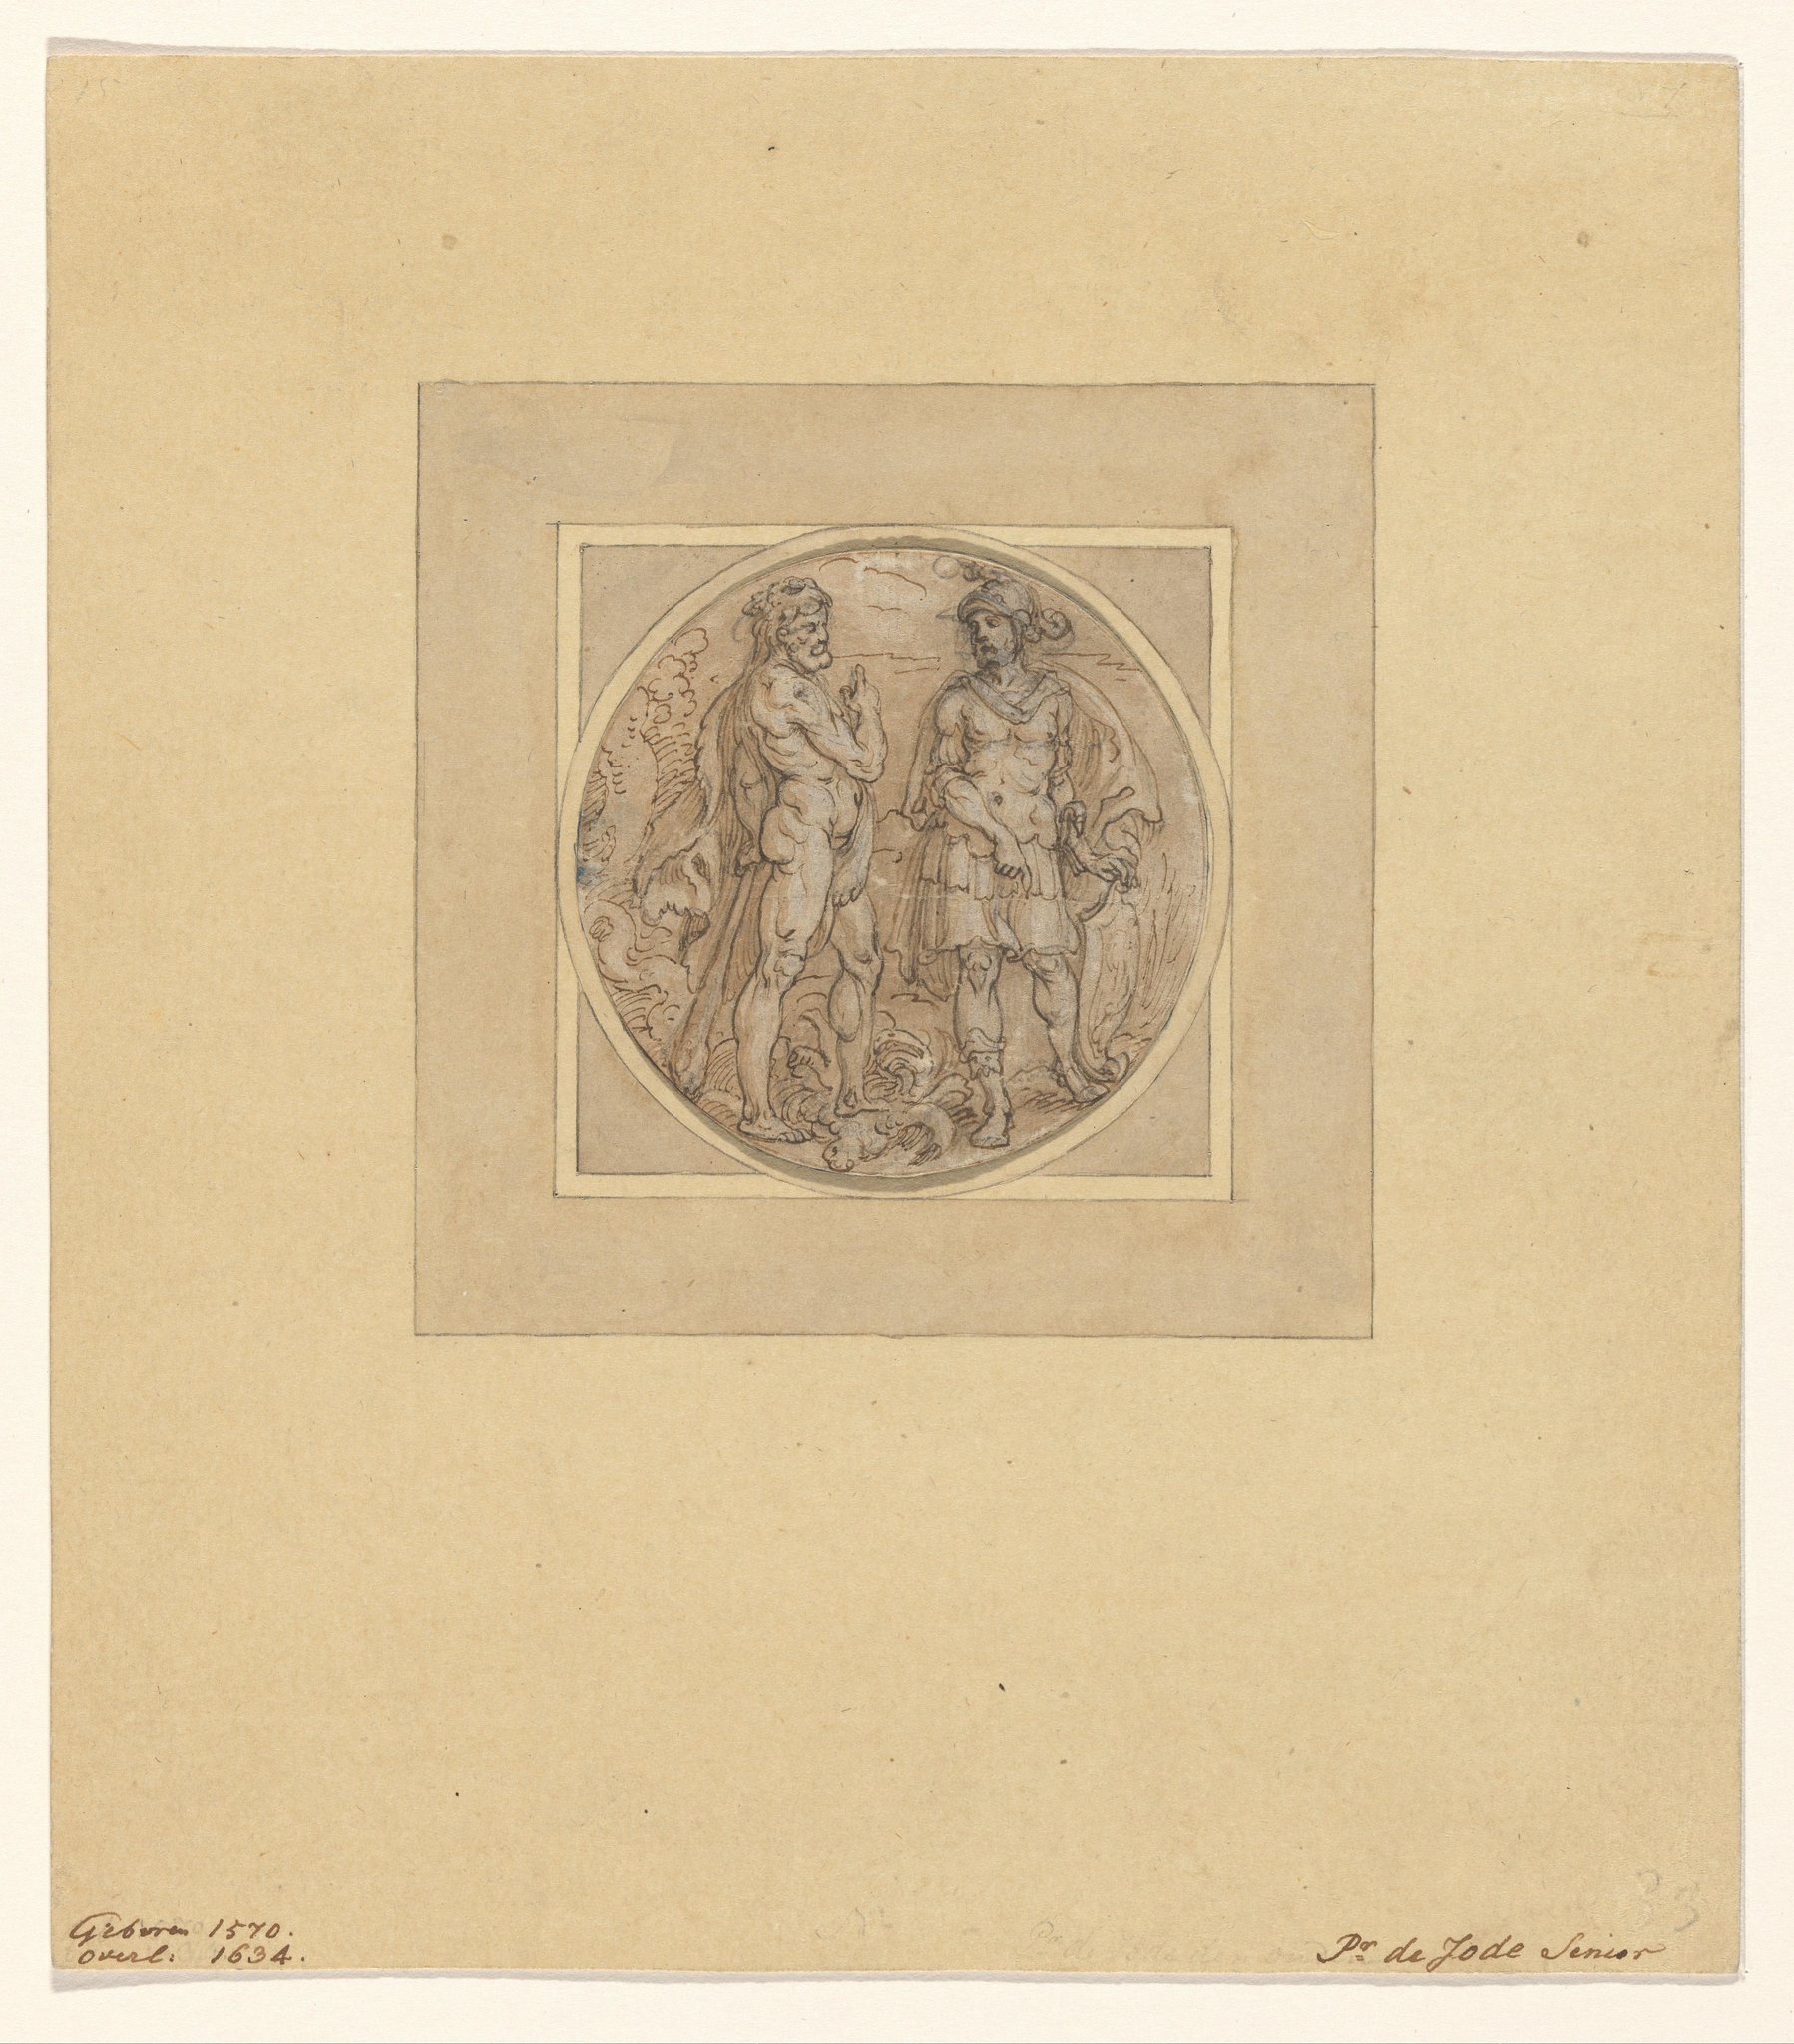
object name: drawing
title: Hercules en Mars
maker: pieter de jode (i)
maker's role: draughtsman, print maker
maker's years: 1570-1634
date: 1583-1634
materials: chalk, paint, ink, paper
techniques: brush, pen